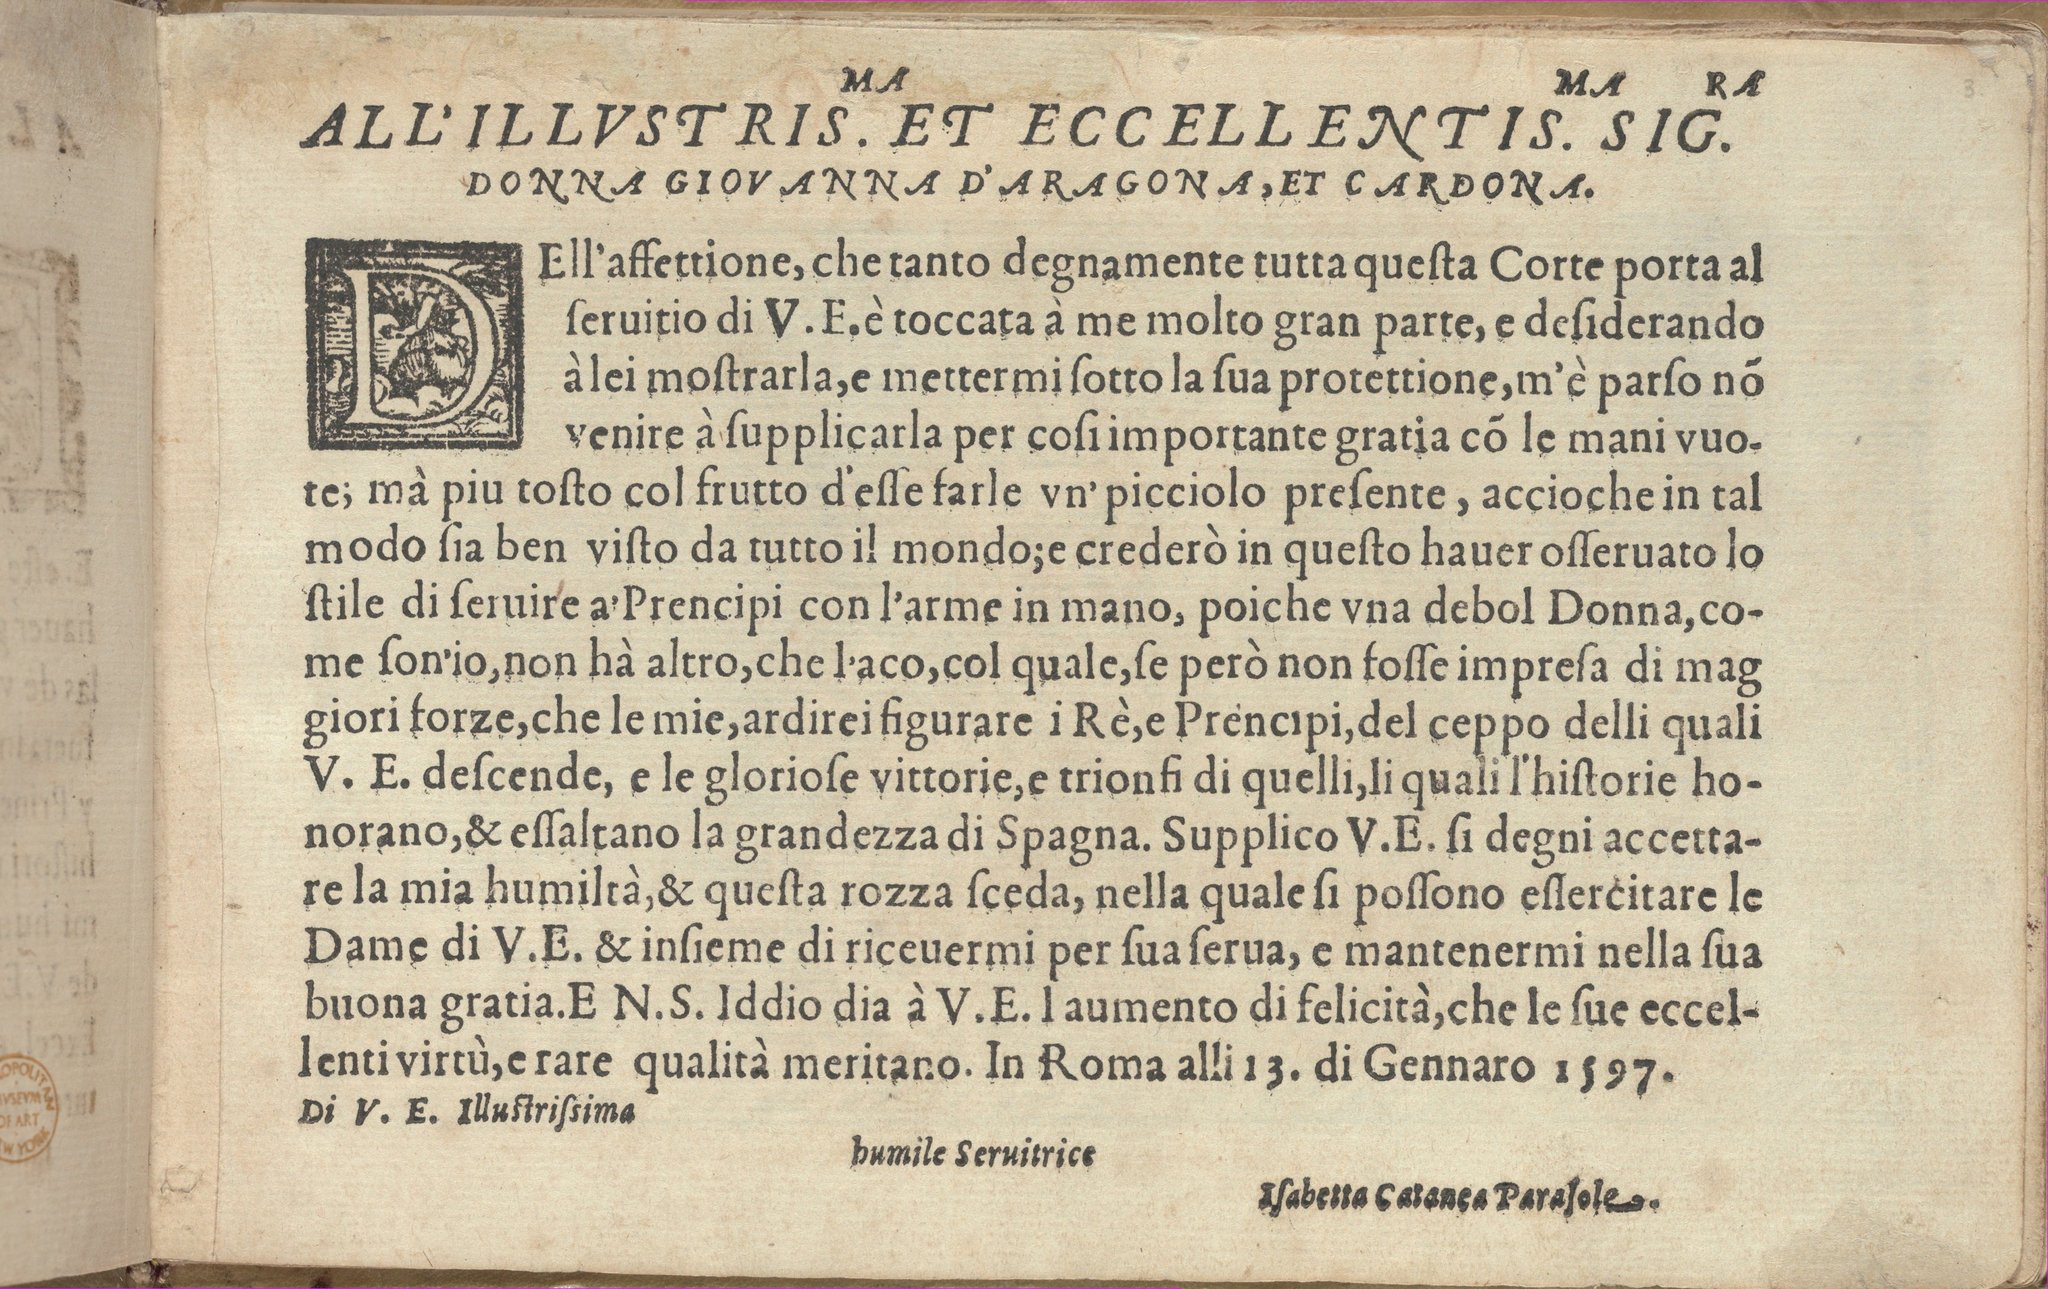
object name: book print ornament architecture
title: Studio delle virtuose Dame, page 3 (recto)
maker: isabella catanea parasole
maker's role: designer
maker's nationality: italian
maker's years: 1565-1625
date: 1597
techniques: woodcut